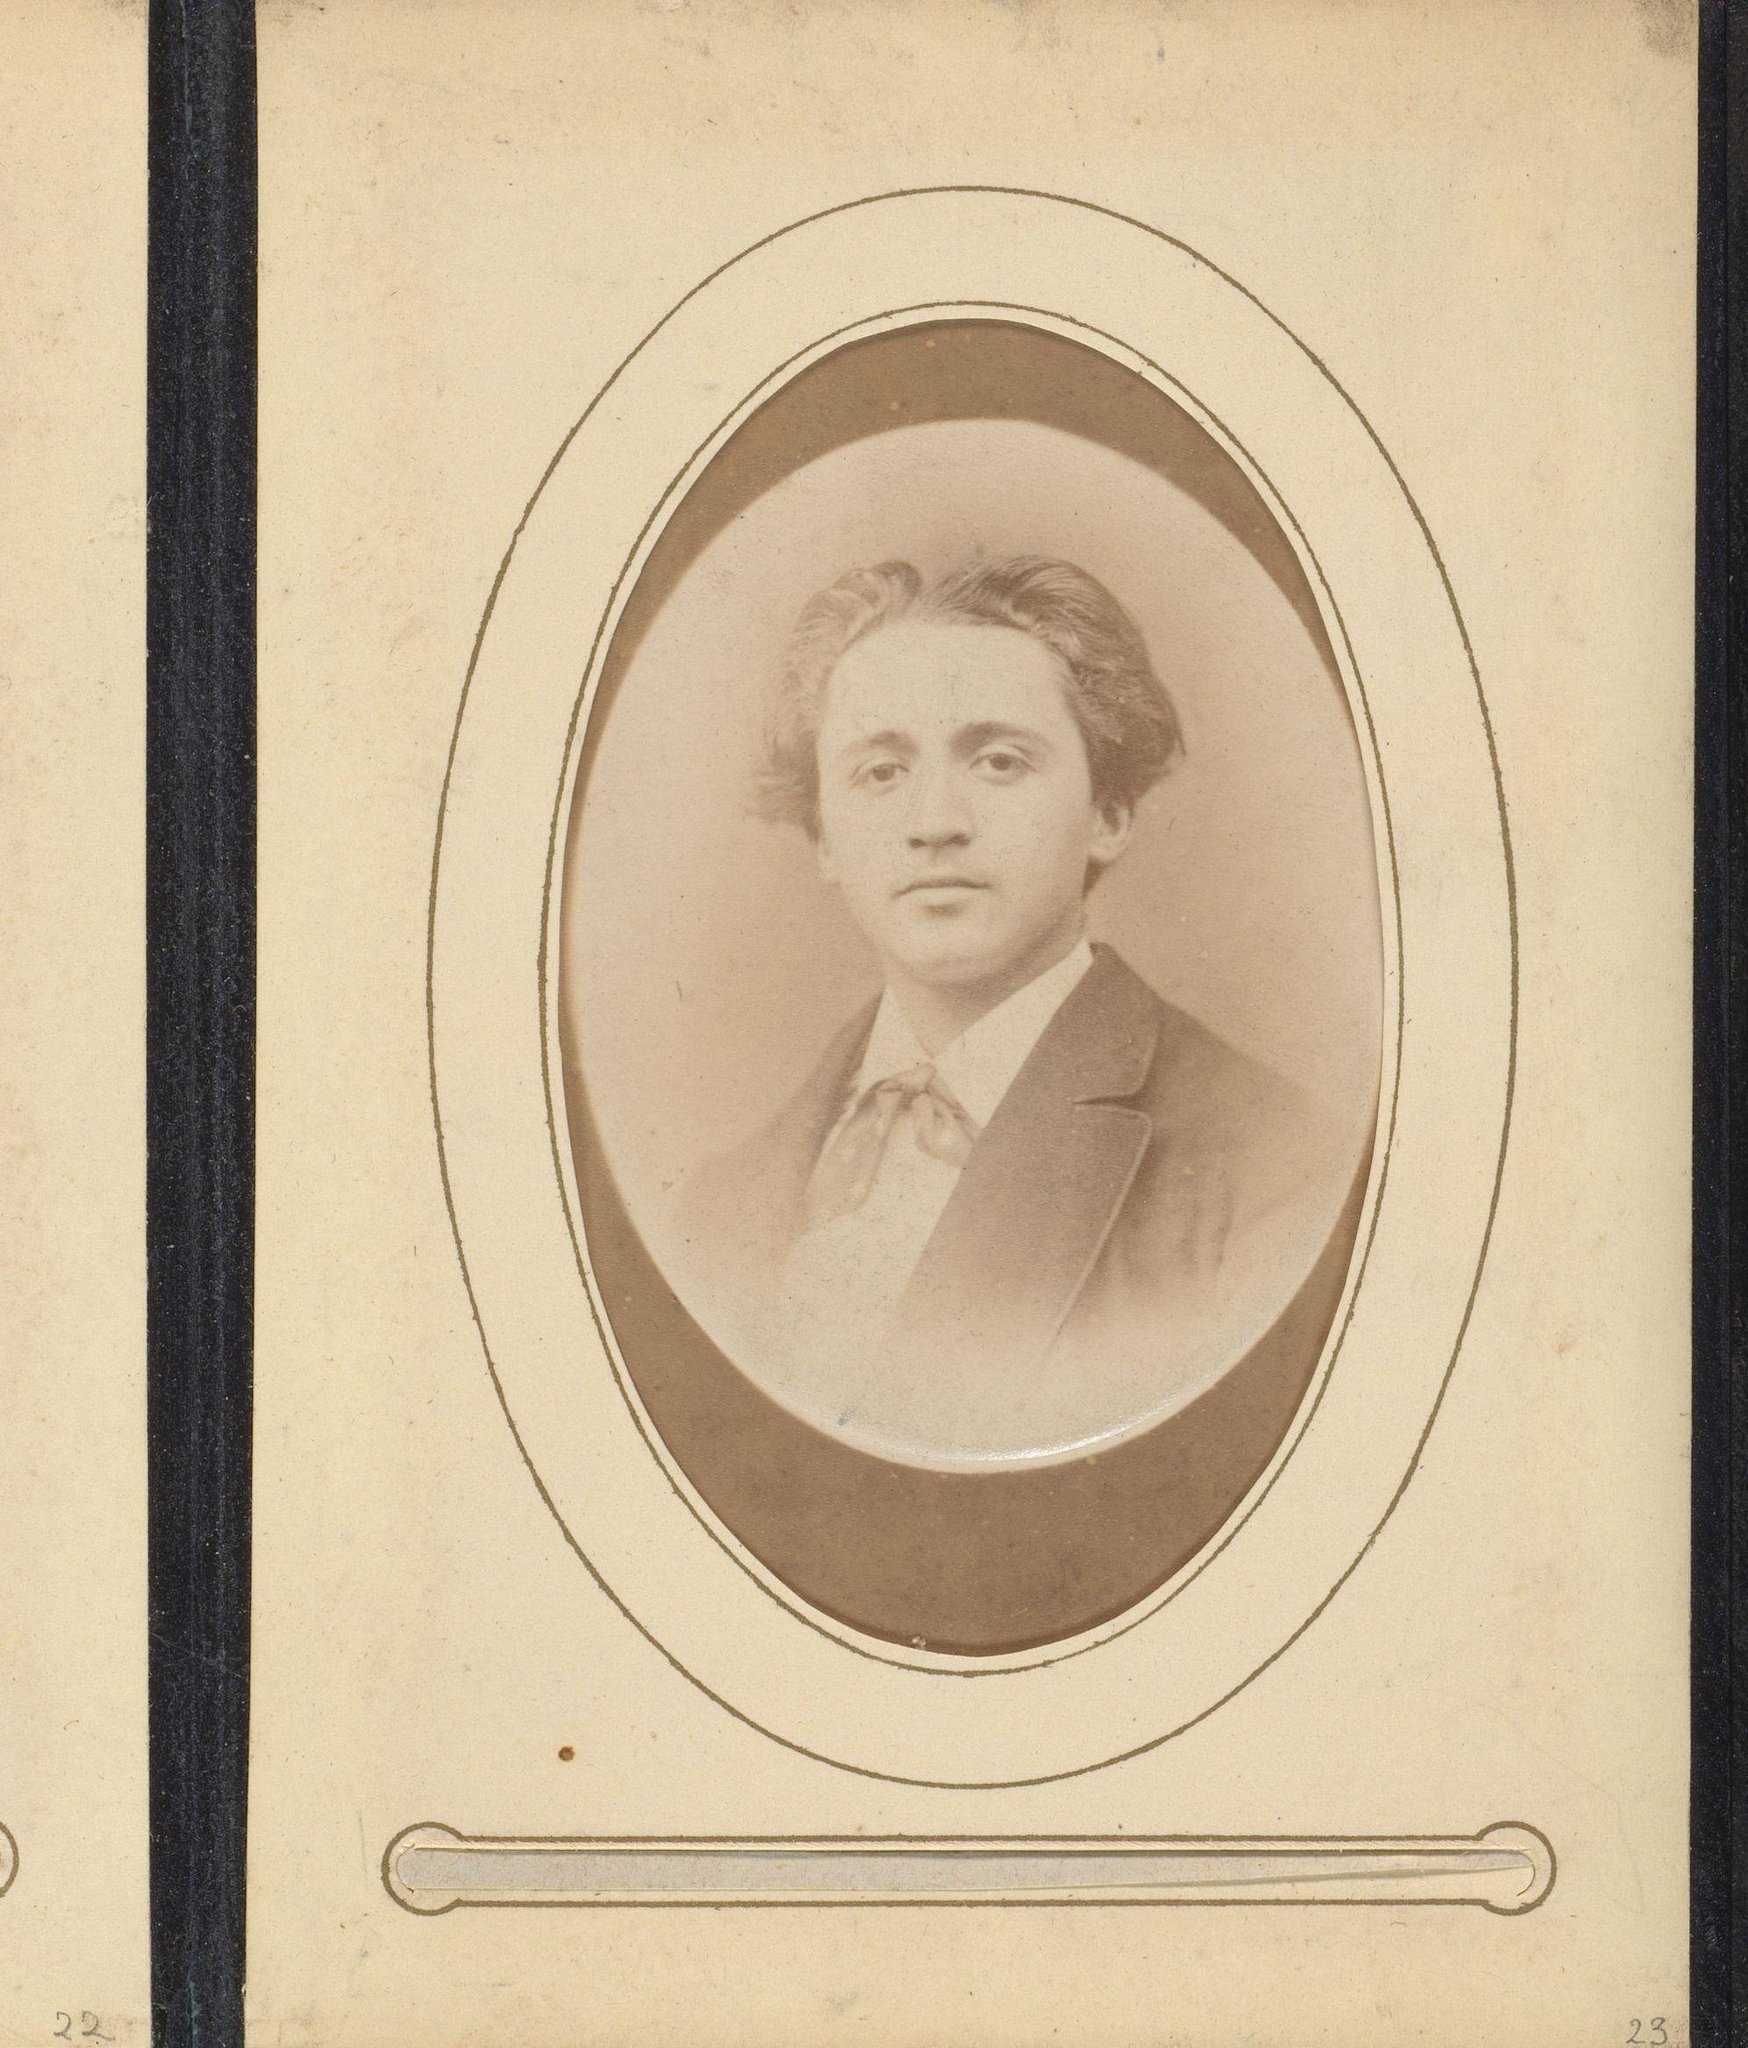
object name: carte de visite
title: Portret van een jongen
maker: ed. radermacher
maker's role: fotograaf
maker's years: 1839-1908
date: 1863-1890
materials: cardboard, photographic support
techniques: albumen print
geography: rotterdam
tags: boy (child between toddler and youth), historical persons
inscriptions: inscription: ‘ED. RADERMACHER/ PHOTOGRAPH/ FIRMA/ (JANSSENS & RADERMACHER)/ KRUISKADE, HOEK KERKLAAN/ ROTTERDAM’